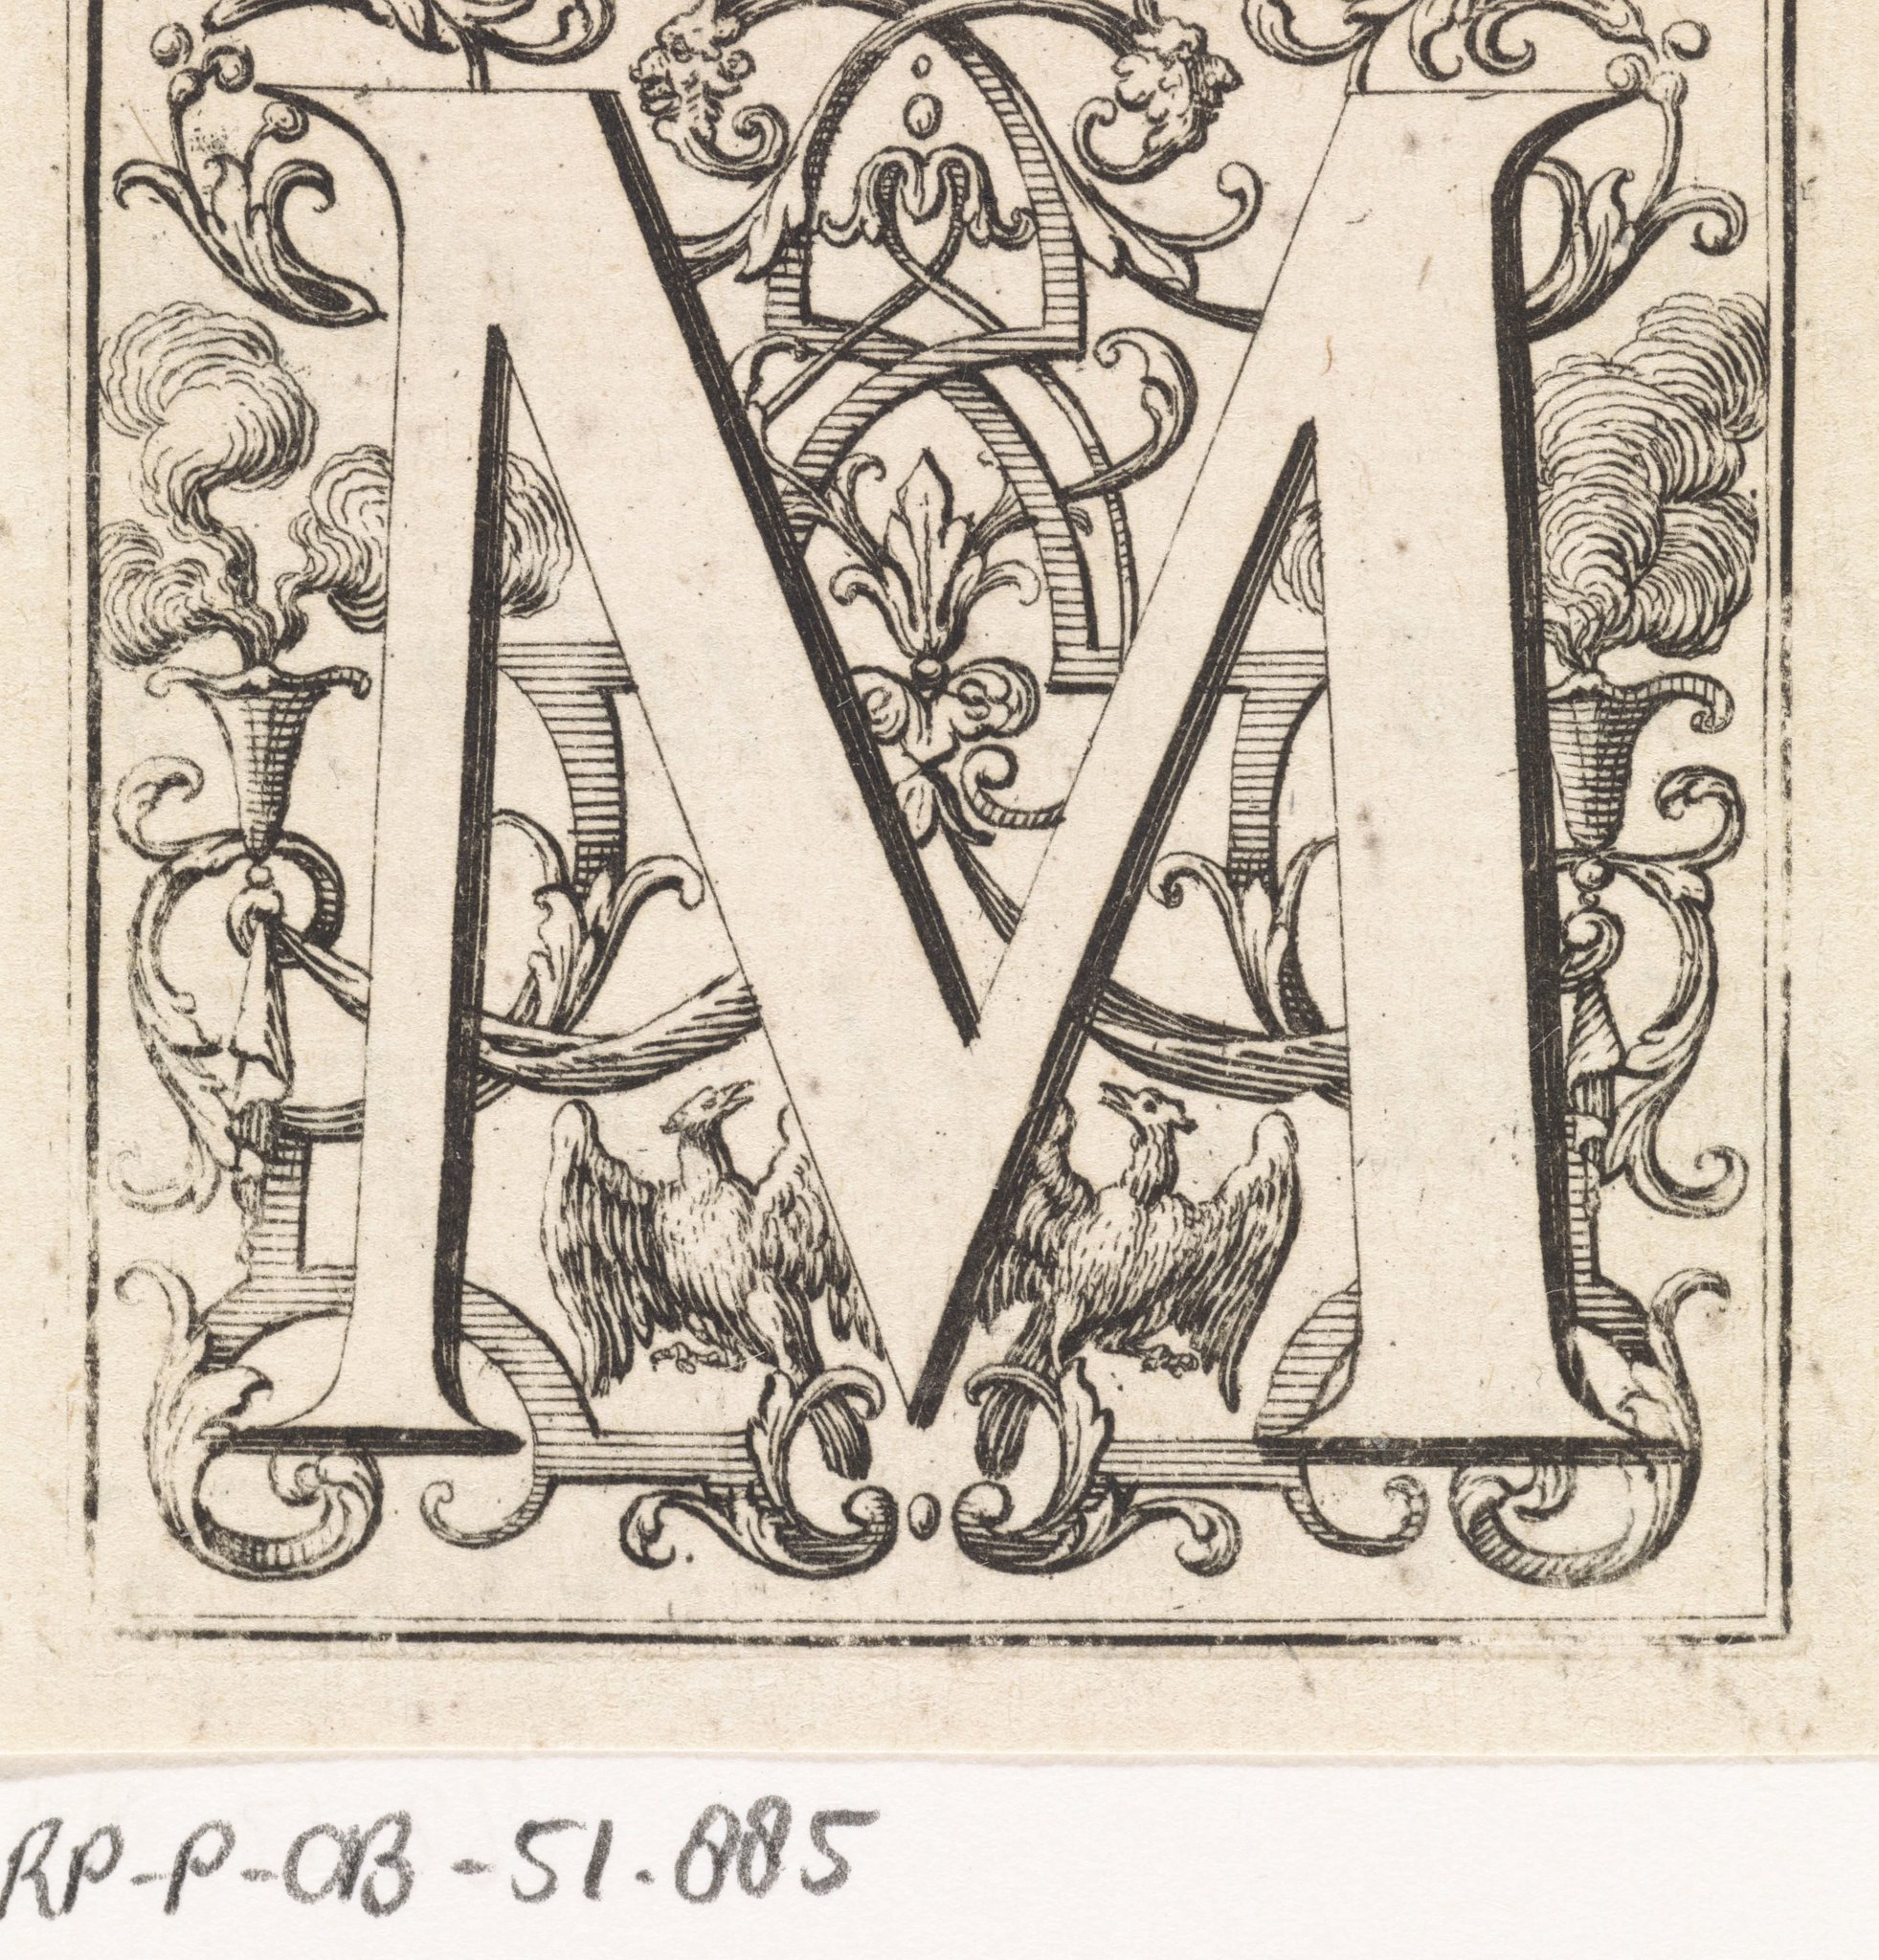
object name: print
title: Letter M met op de achtergrond ornament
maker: bernard picart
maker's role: draughtsman, print maker, publisher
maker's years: 1673-1733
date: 1683-1733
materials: paper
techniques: engraving, etching, letterpress printing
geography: amsterdam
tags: historiated initial, foliage, tendrils, branches ~ ornament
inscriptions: collector's mark: Lugt 2228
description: De letter en het inititaal M met op de achtergrond ornament van bladmotieven en midden onder twee vogels.